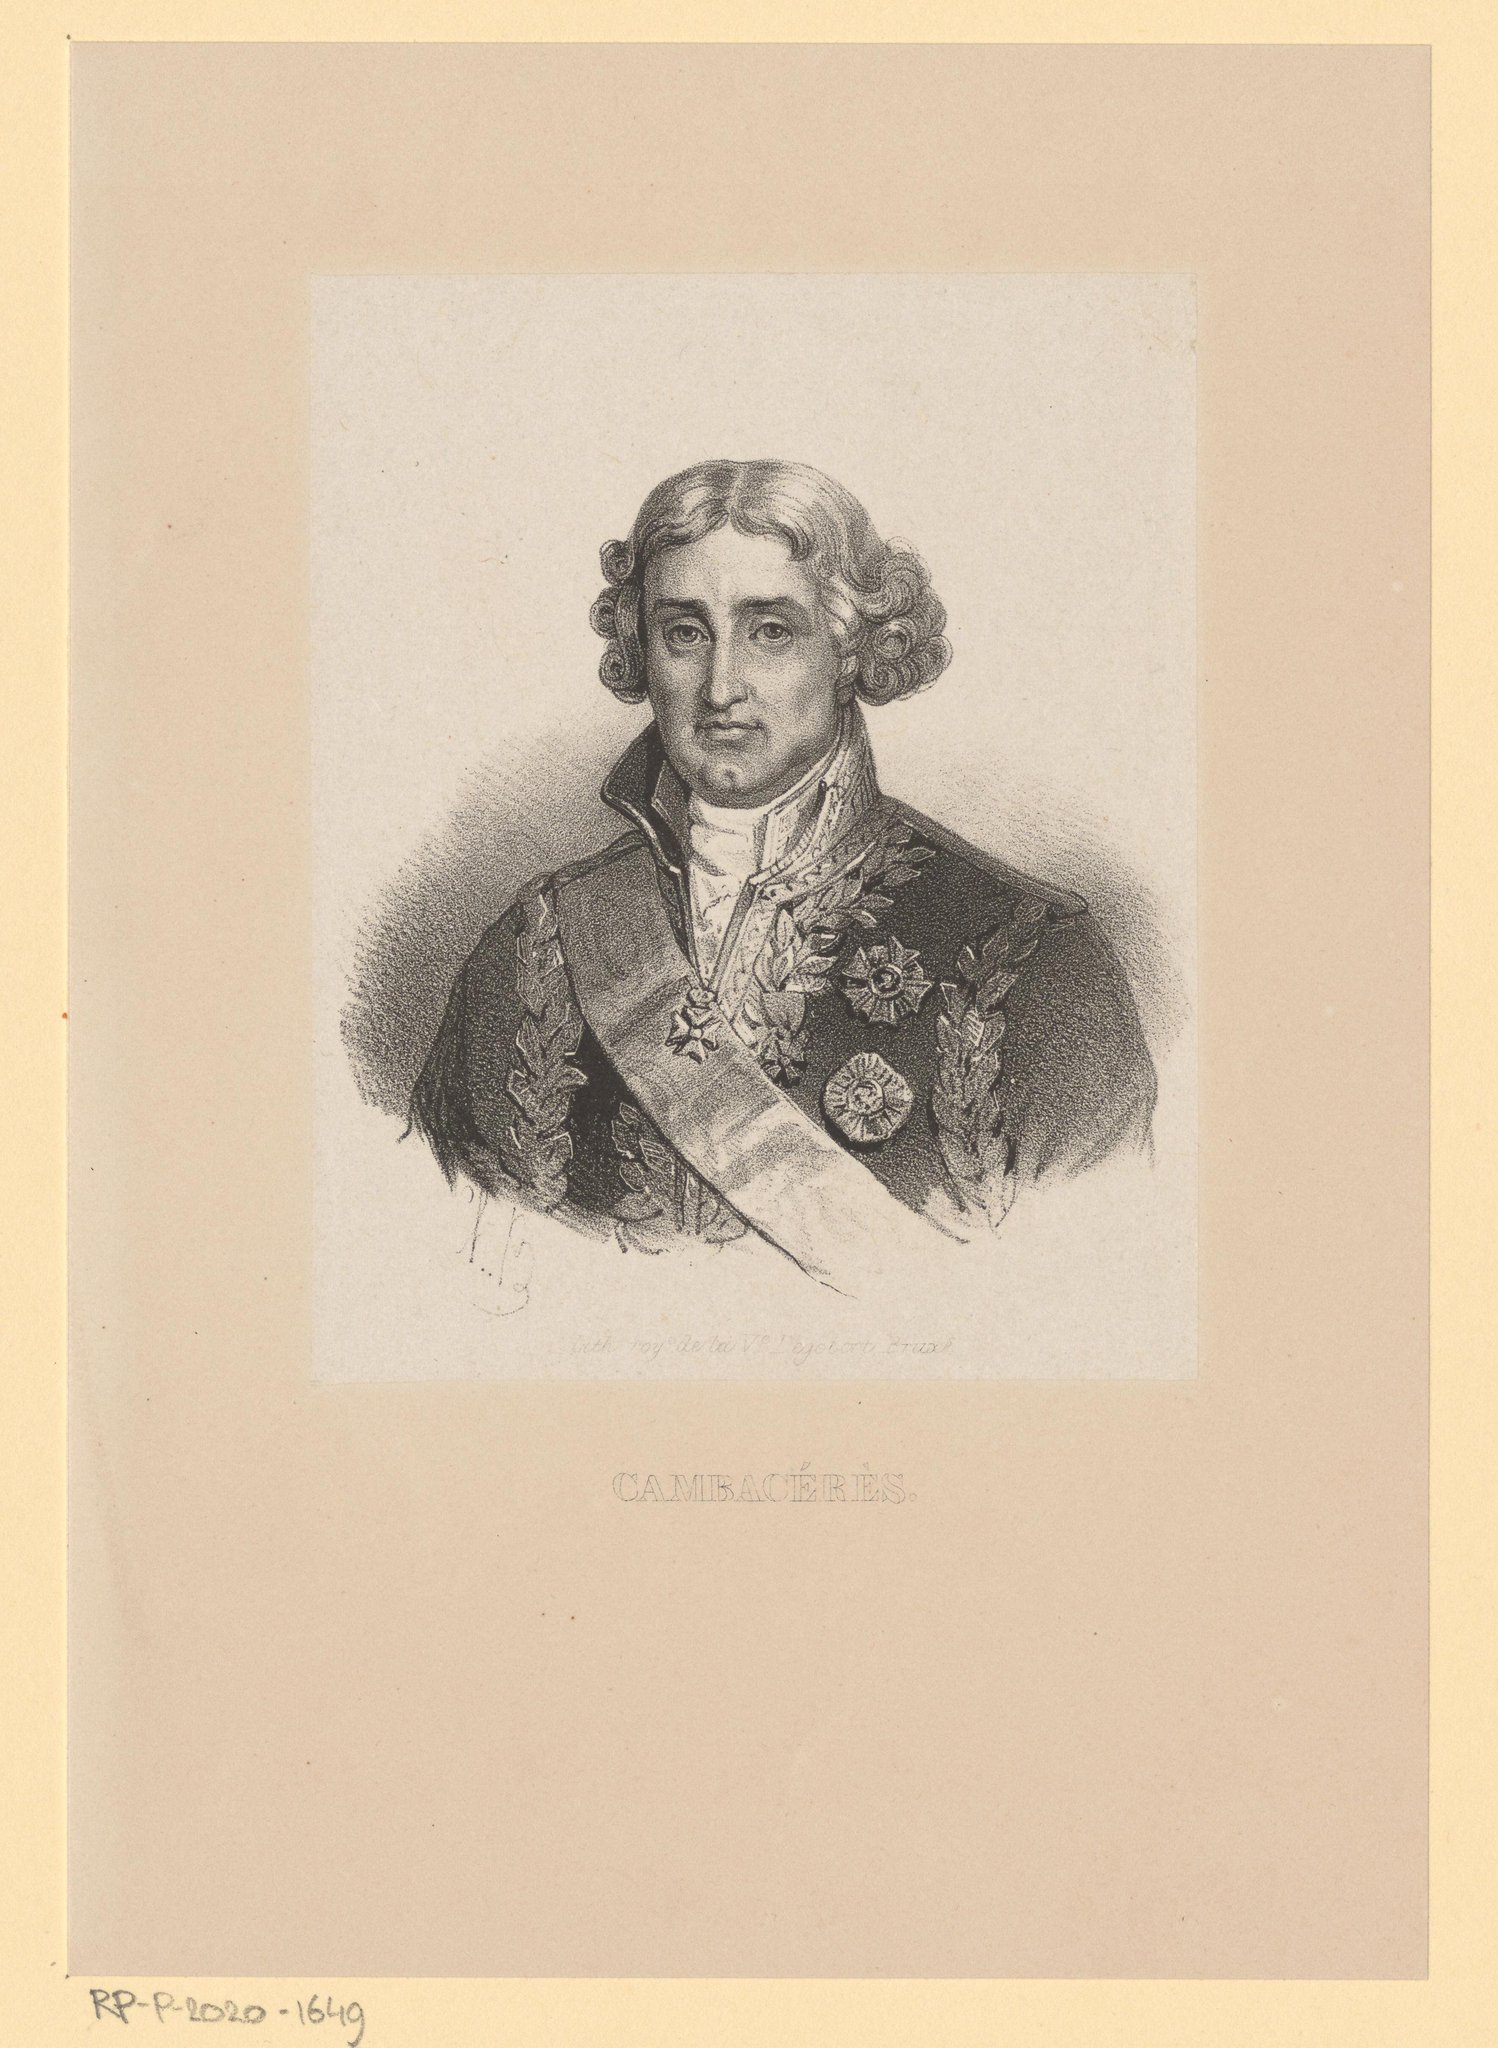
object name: print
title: Portret van Jean-Jacques Régis de Cambacérès, hertog van Parma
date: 1844-1849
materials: paper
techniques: lithograph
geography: brussels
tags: paris, politician, historical persons